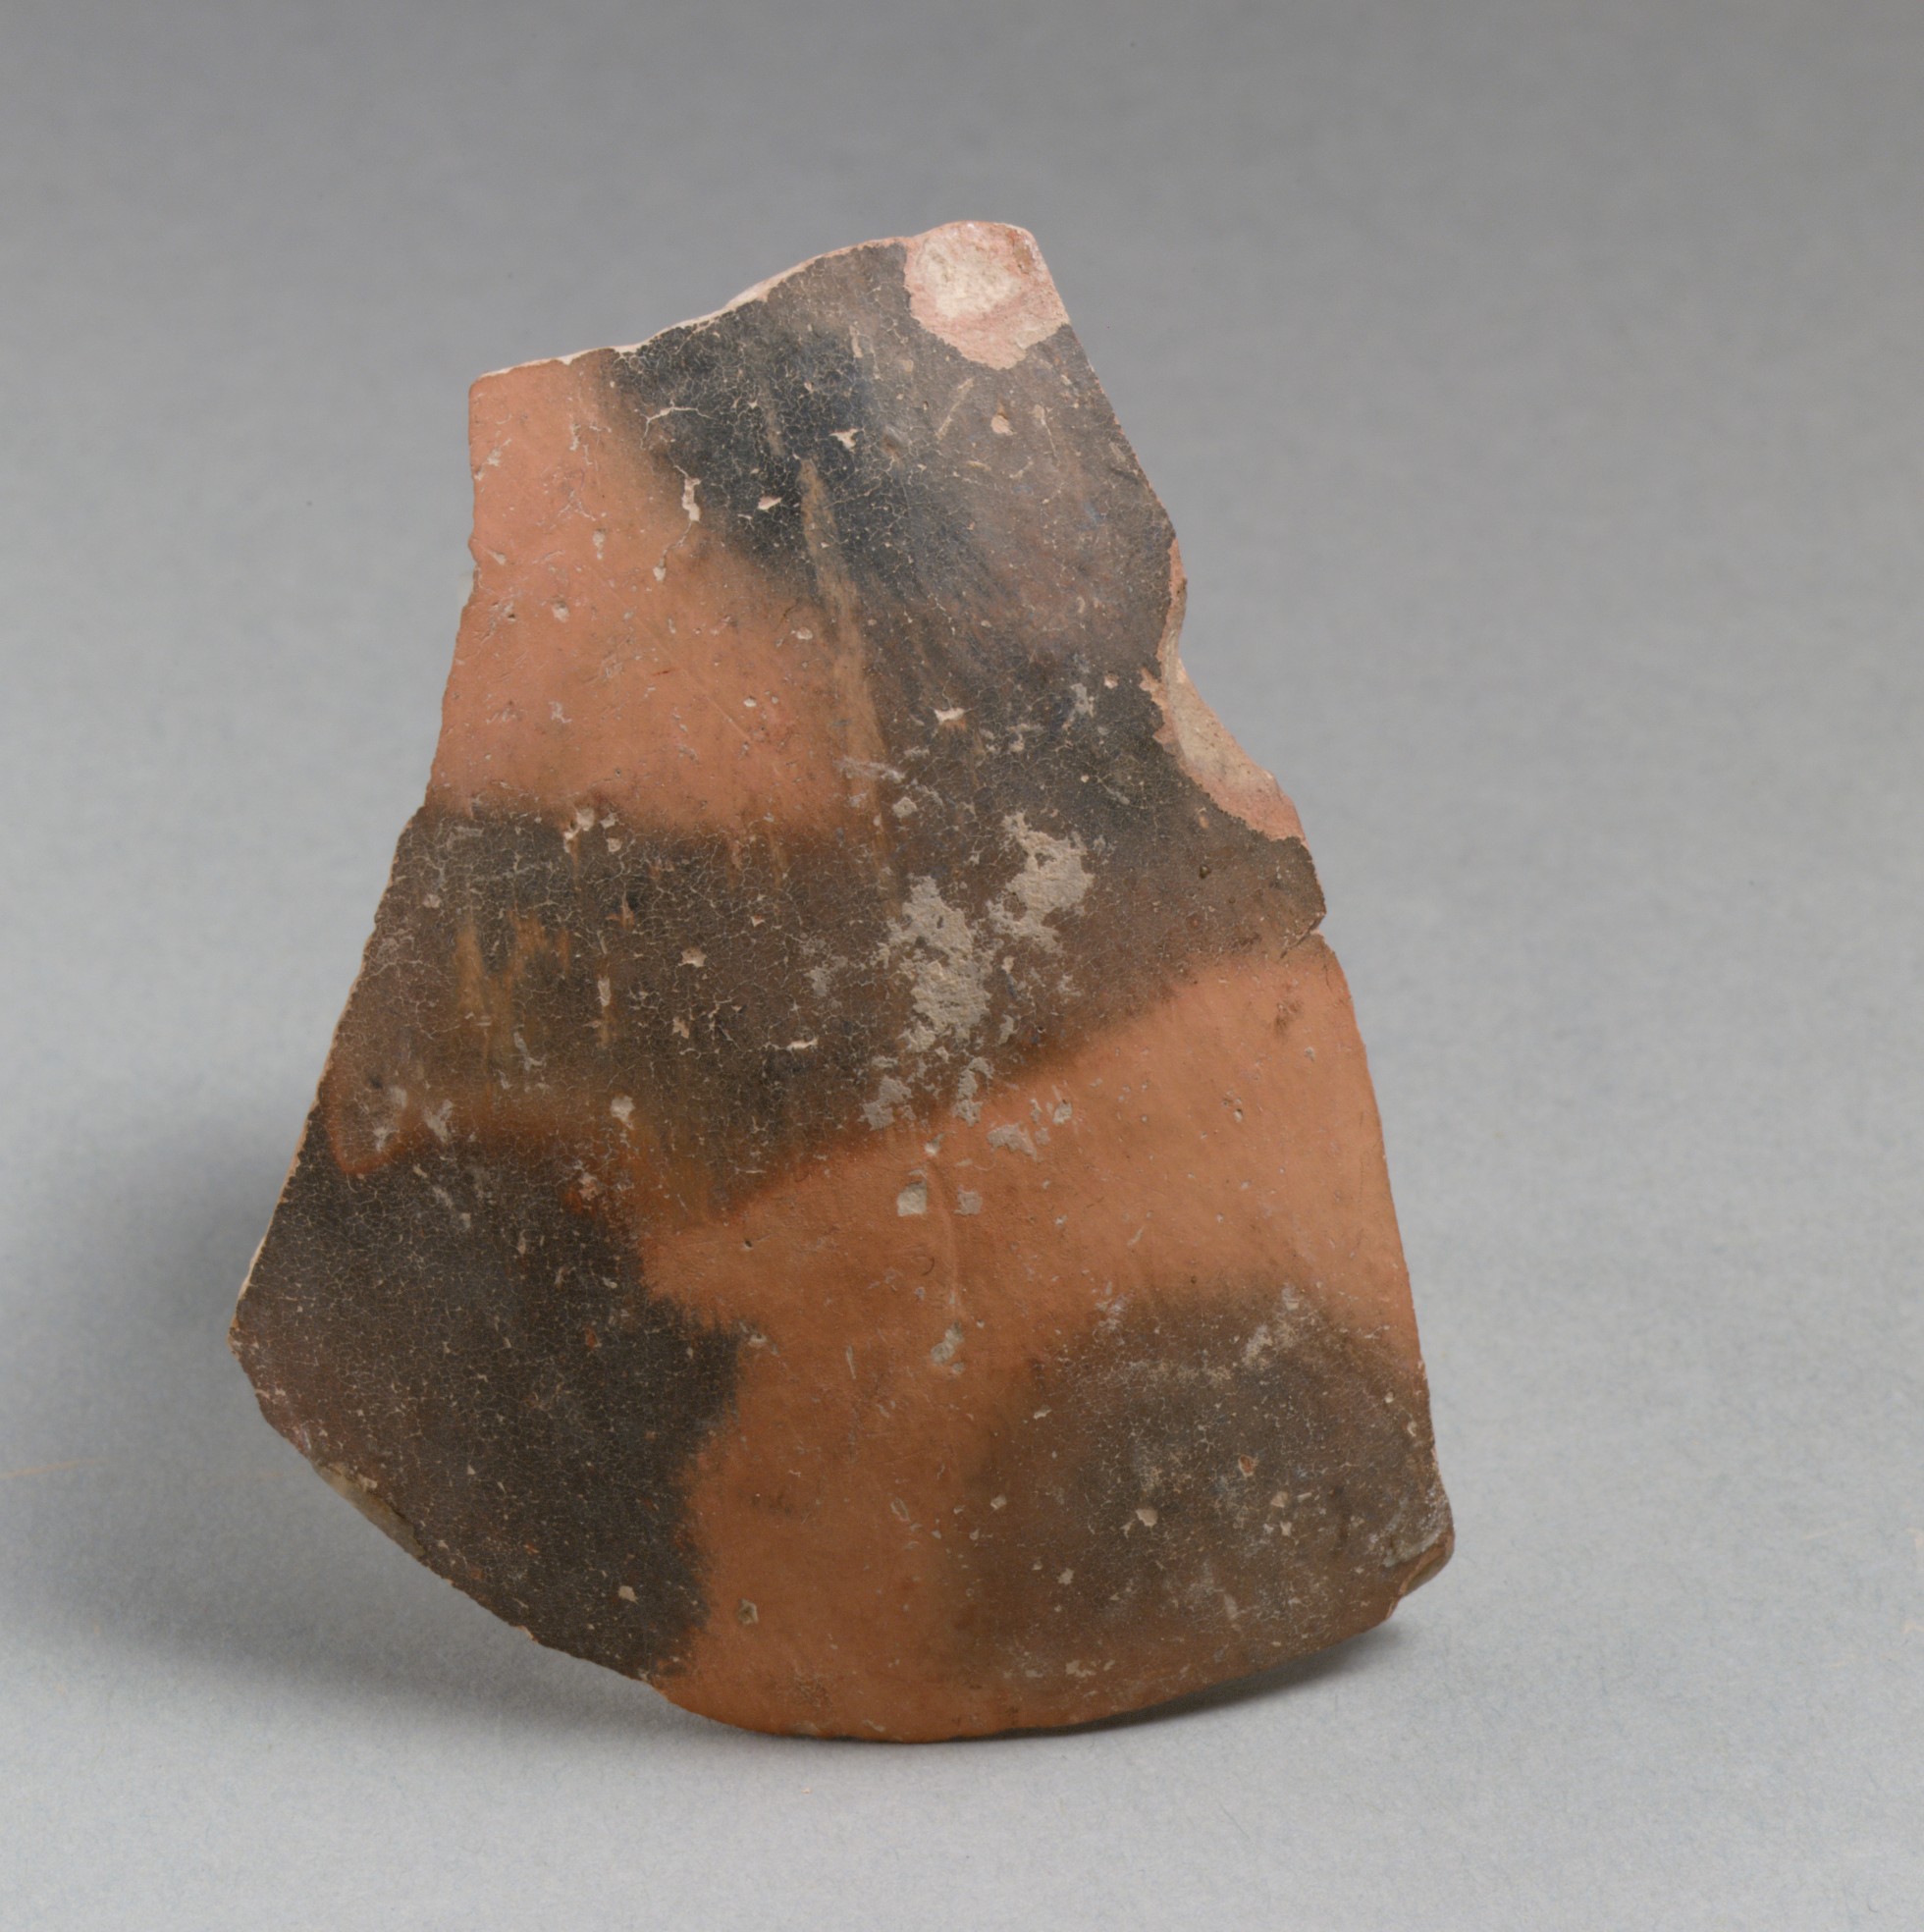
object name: vase fragment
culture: minoan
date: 2600-2000 BCE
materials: terracotta